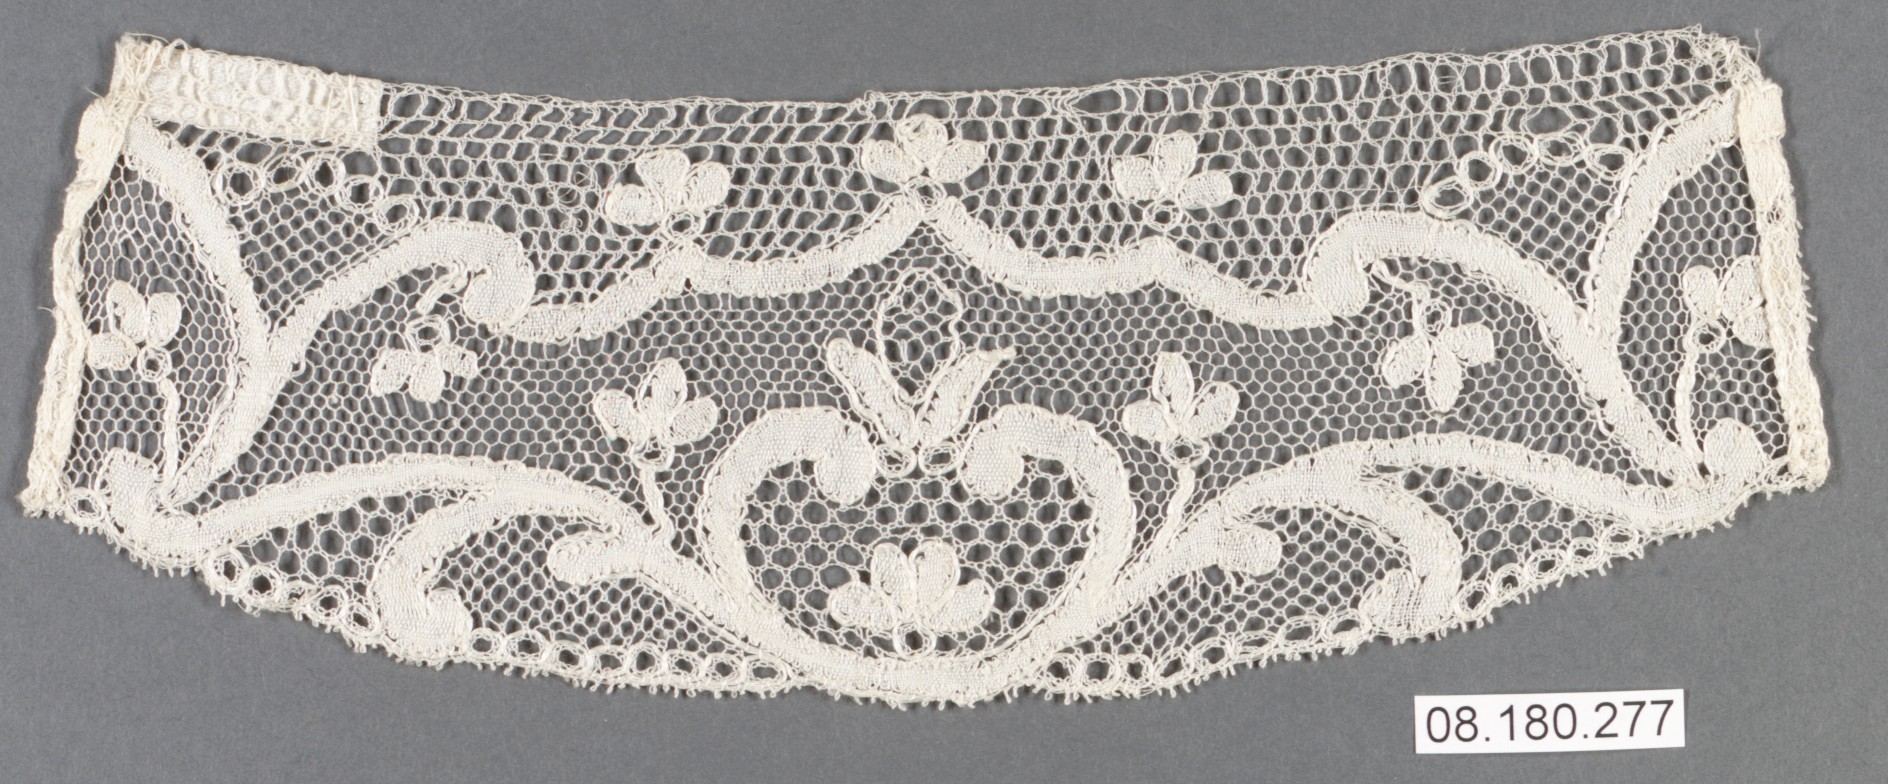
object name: piece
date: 1801-1900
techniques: lace